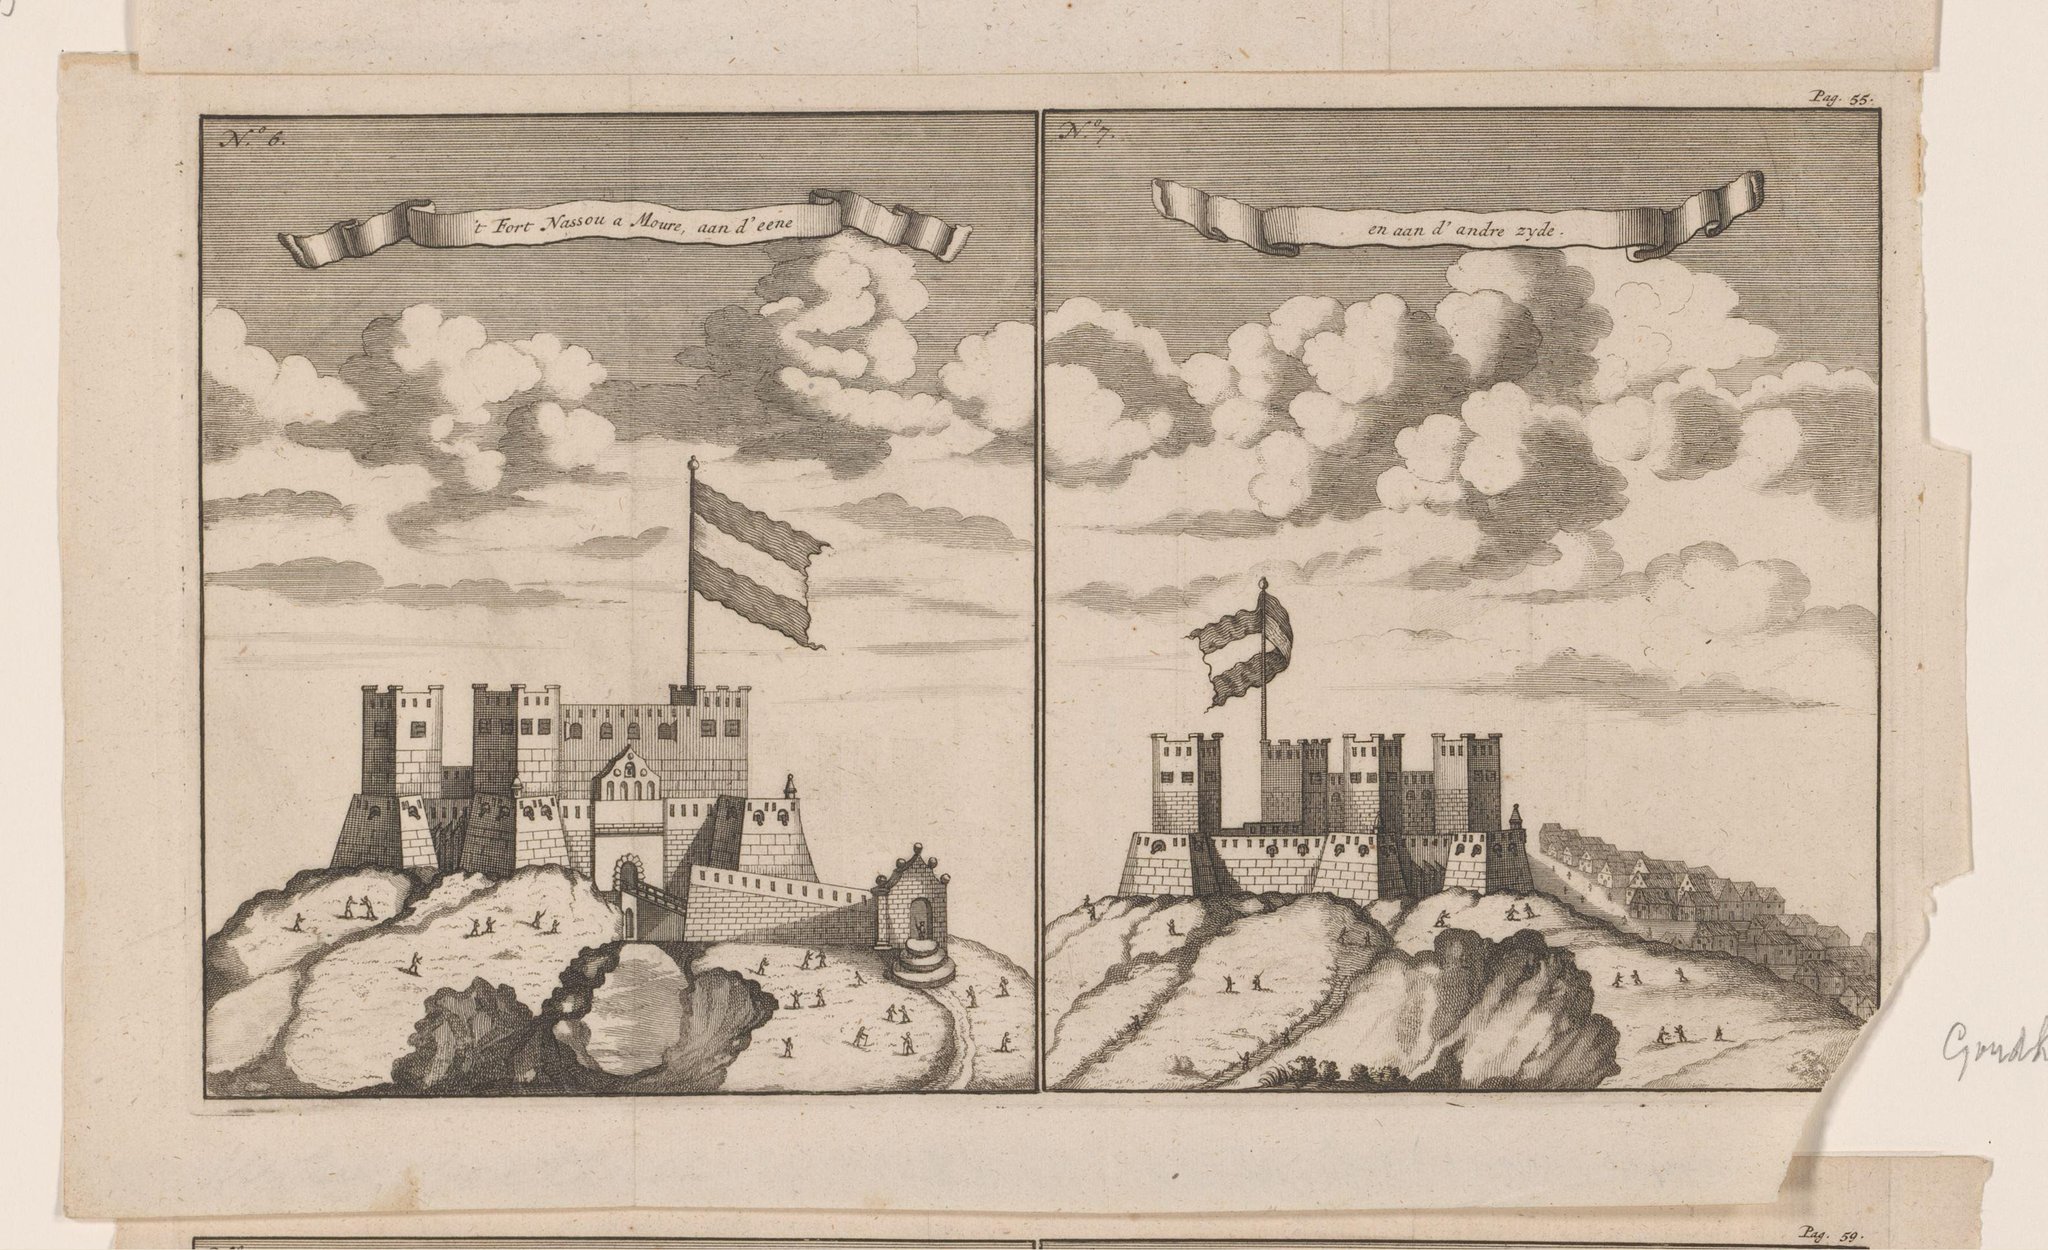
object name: book illustration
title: 't Fort Nassou a Moure, aan d' eene / en aan d'andre zyde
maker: Anonymous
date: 1704-1737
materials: paper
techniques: etching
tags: fortress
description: Prent gebruikt in Willems Bosmans 'Nauwkeurige beschryving van de Guinese goud- tand- en slavekust', tussen 1704 en 1737 uitgegeven door verschillende uitgevers.